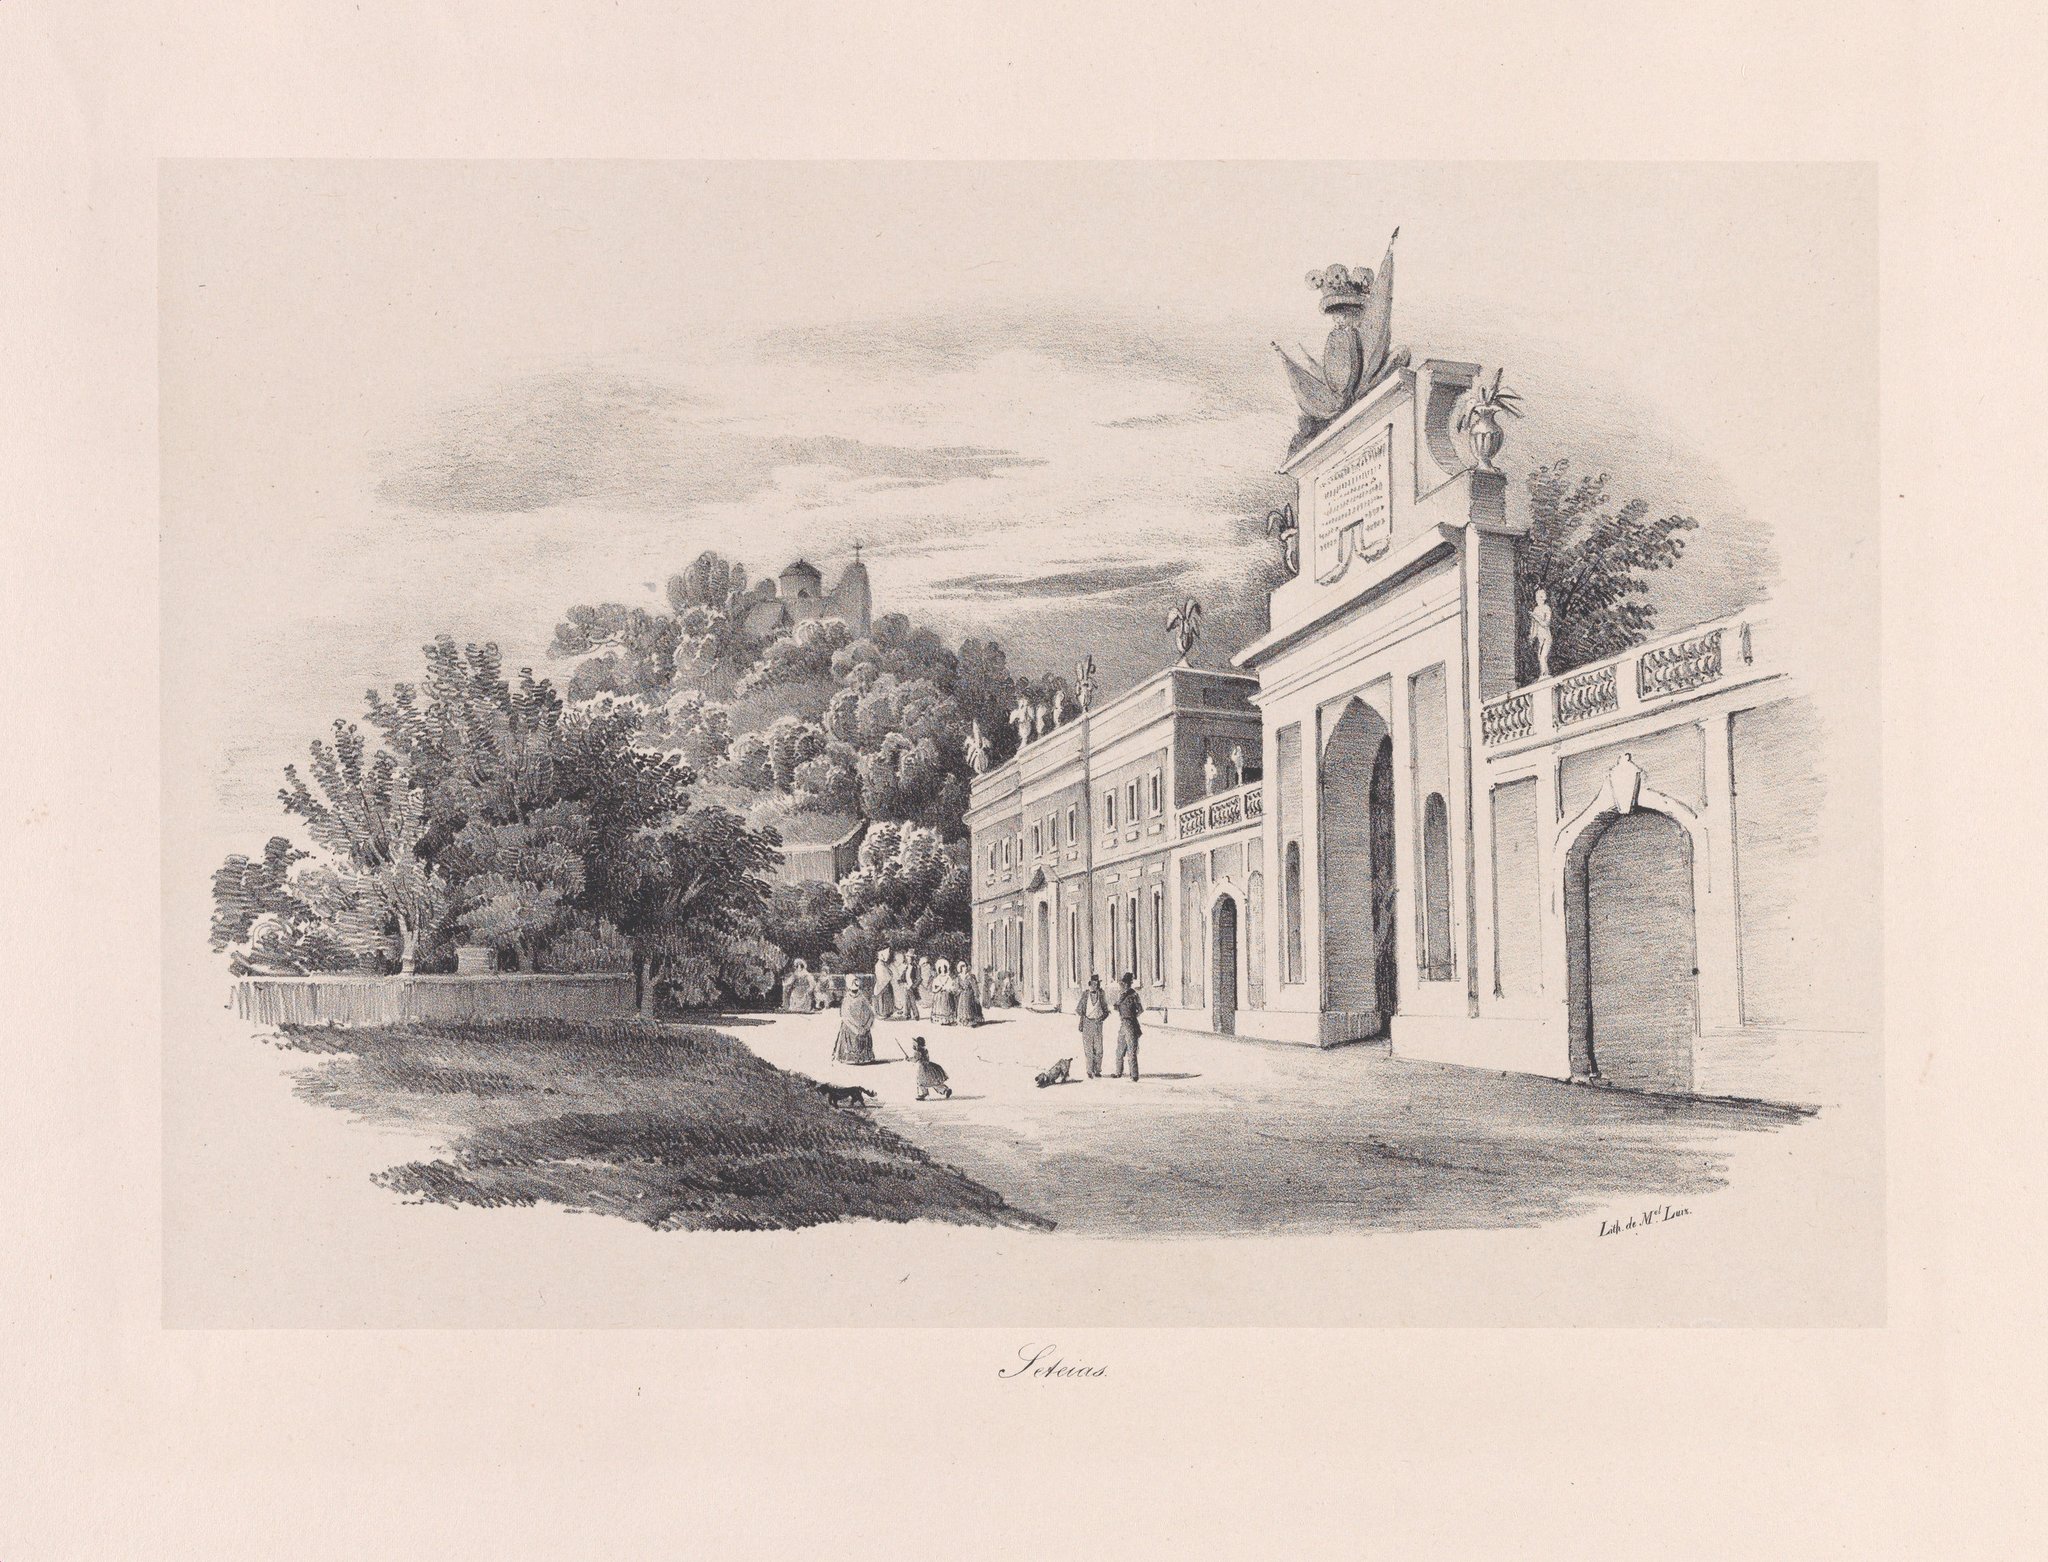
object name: print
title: View of the entrance to the Palacio de Seteais, Sintra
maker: clementine de brelaz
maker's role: artist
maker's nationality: portuguese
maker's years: 1811-1892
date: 1840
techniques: printmaking, lithograph